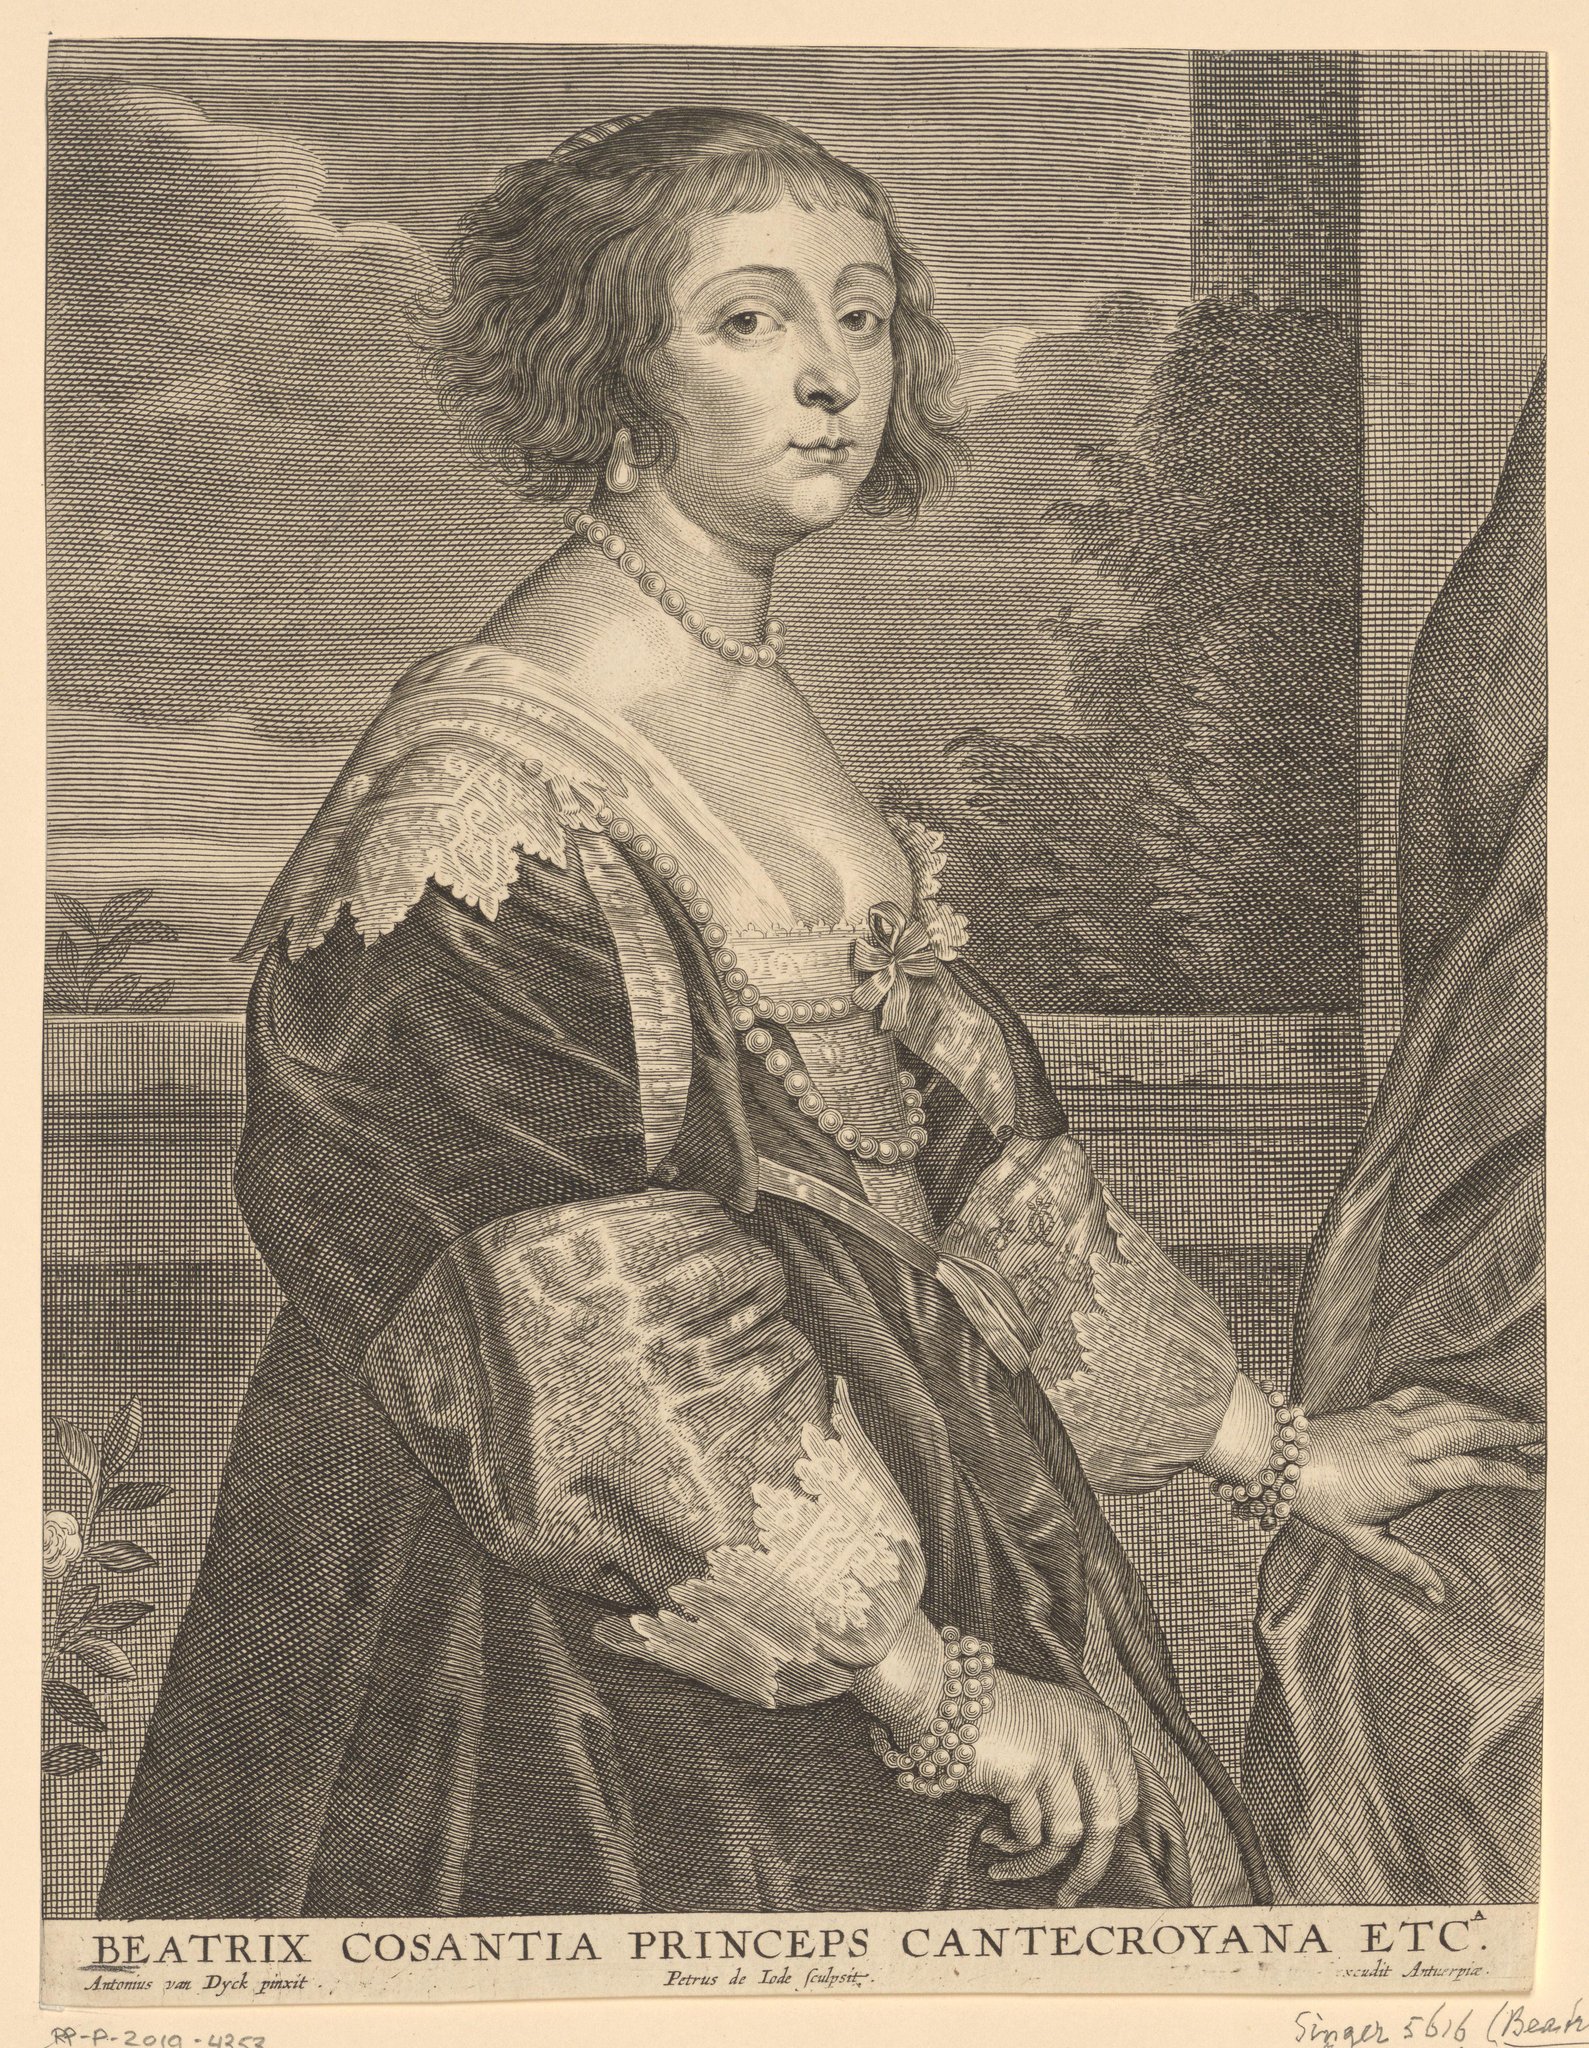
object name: print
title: Portret van Béatrix de Cusance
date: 1628-1670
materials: paper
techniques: engraving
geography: antwerp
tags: historical persons - bb - woman